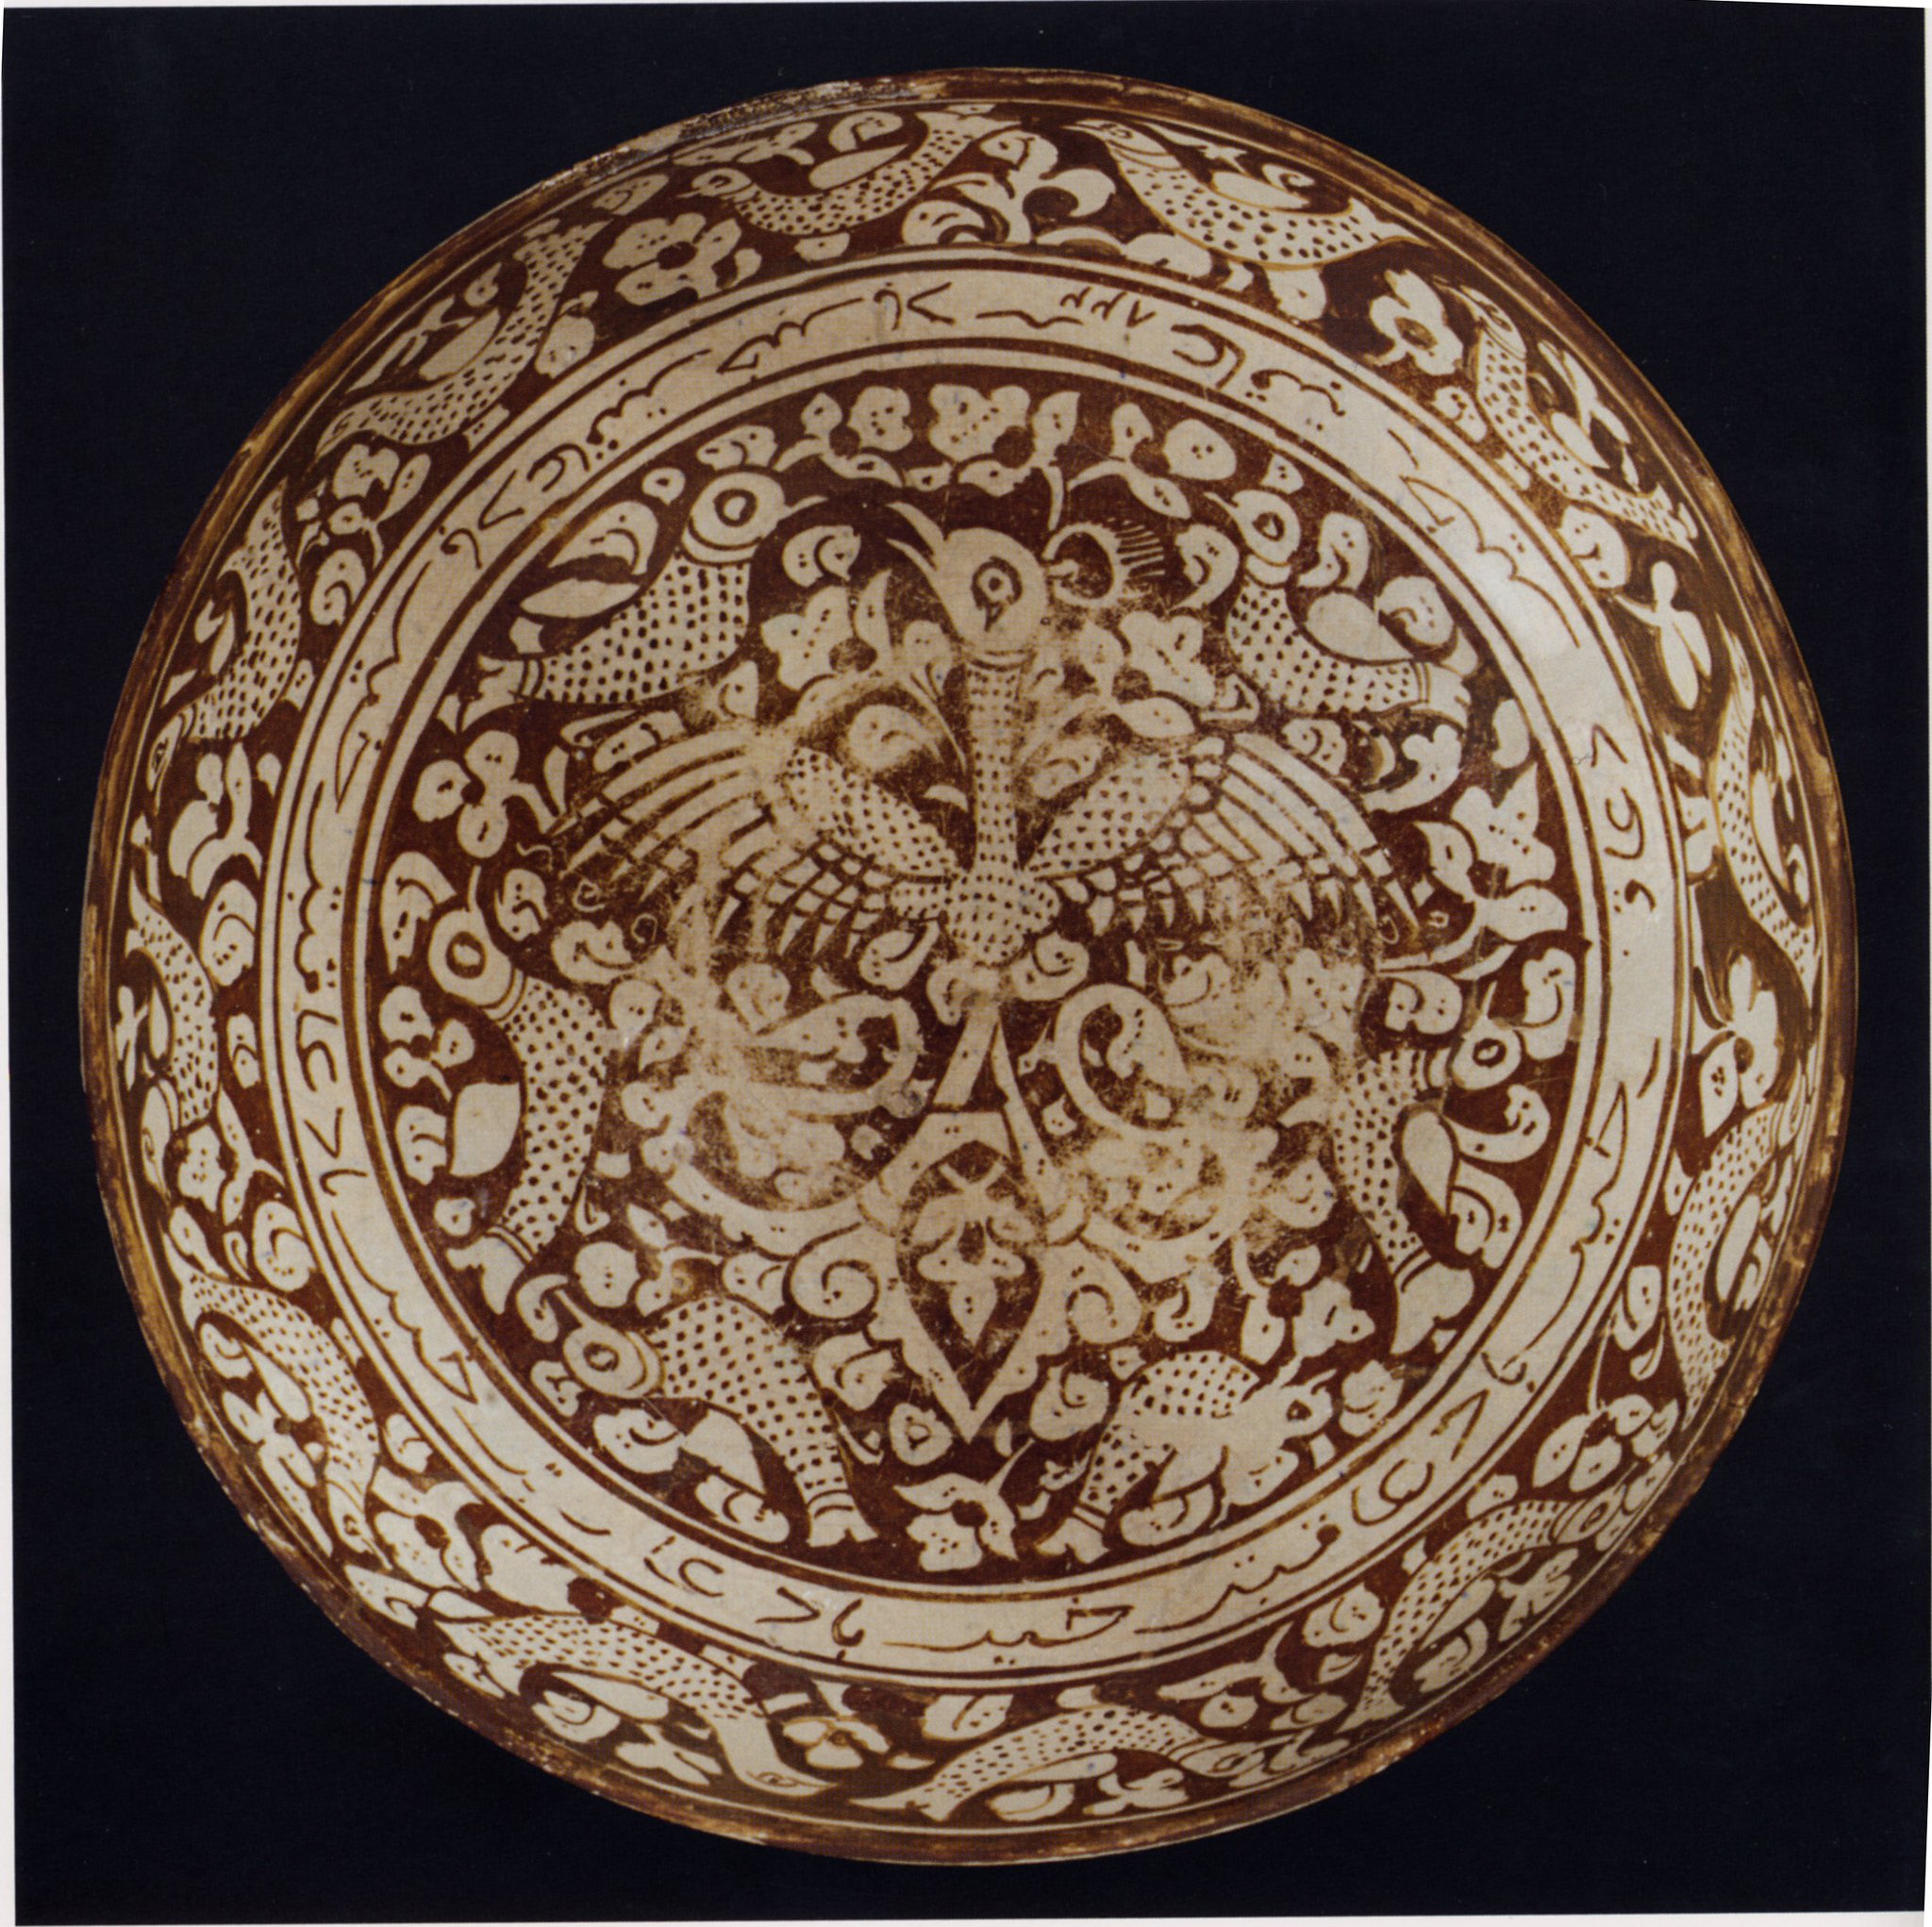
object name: bowl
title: Bowl with Repeating Persian Inscription Wishing for Good Fortune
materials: glaze, stonepaste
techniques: luster painting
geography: afghanistan or iran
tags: birds,leaves